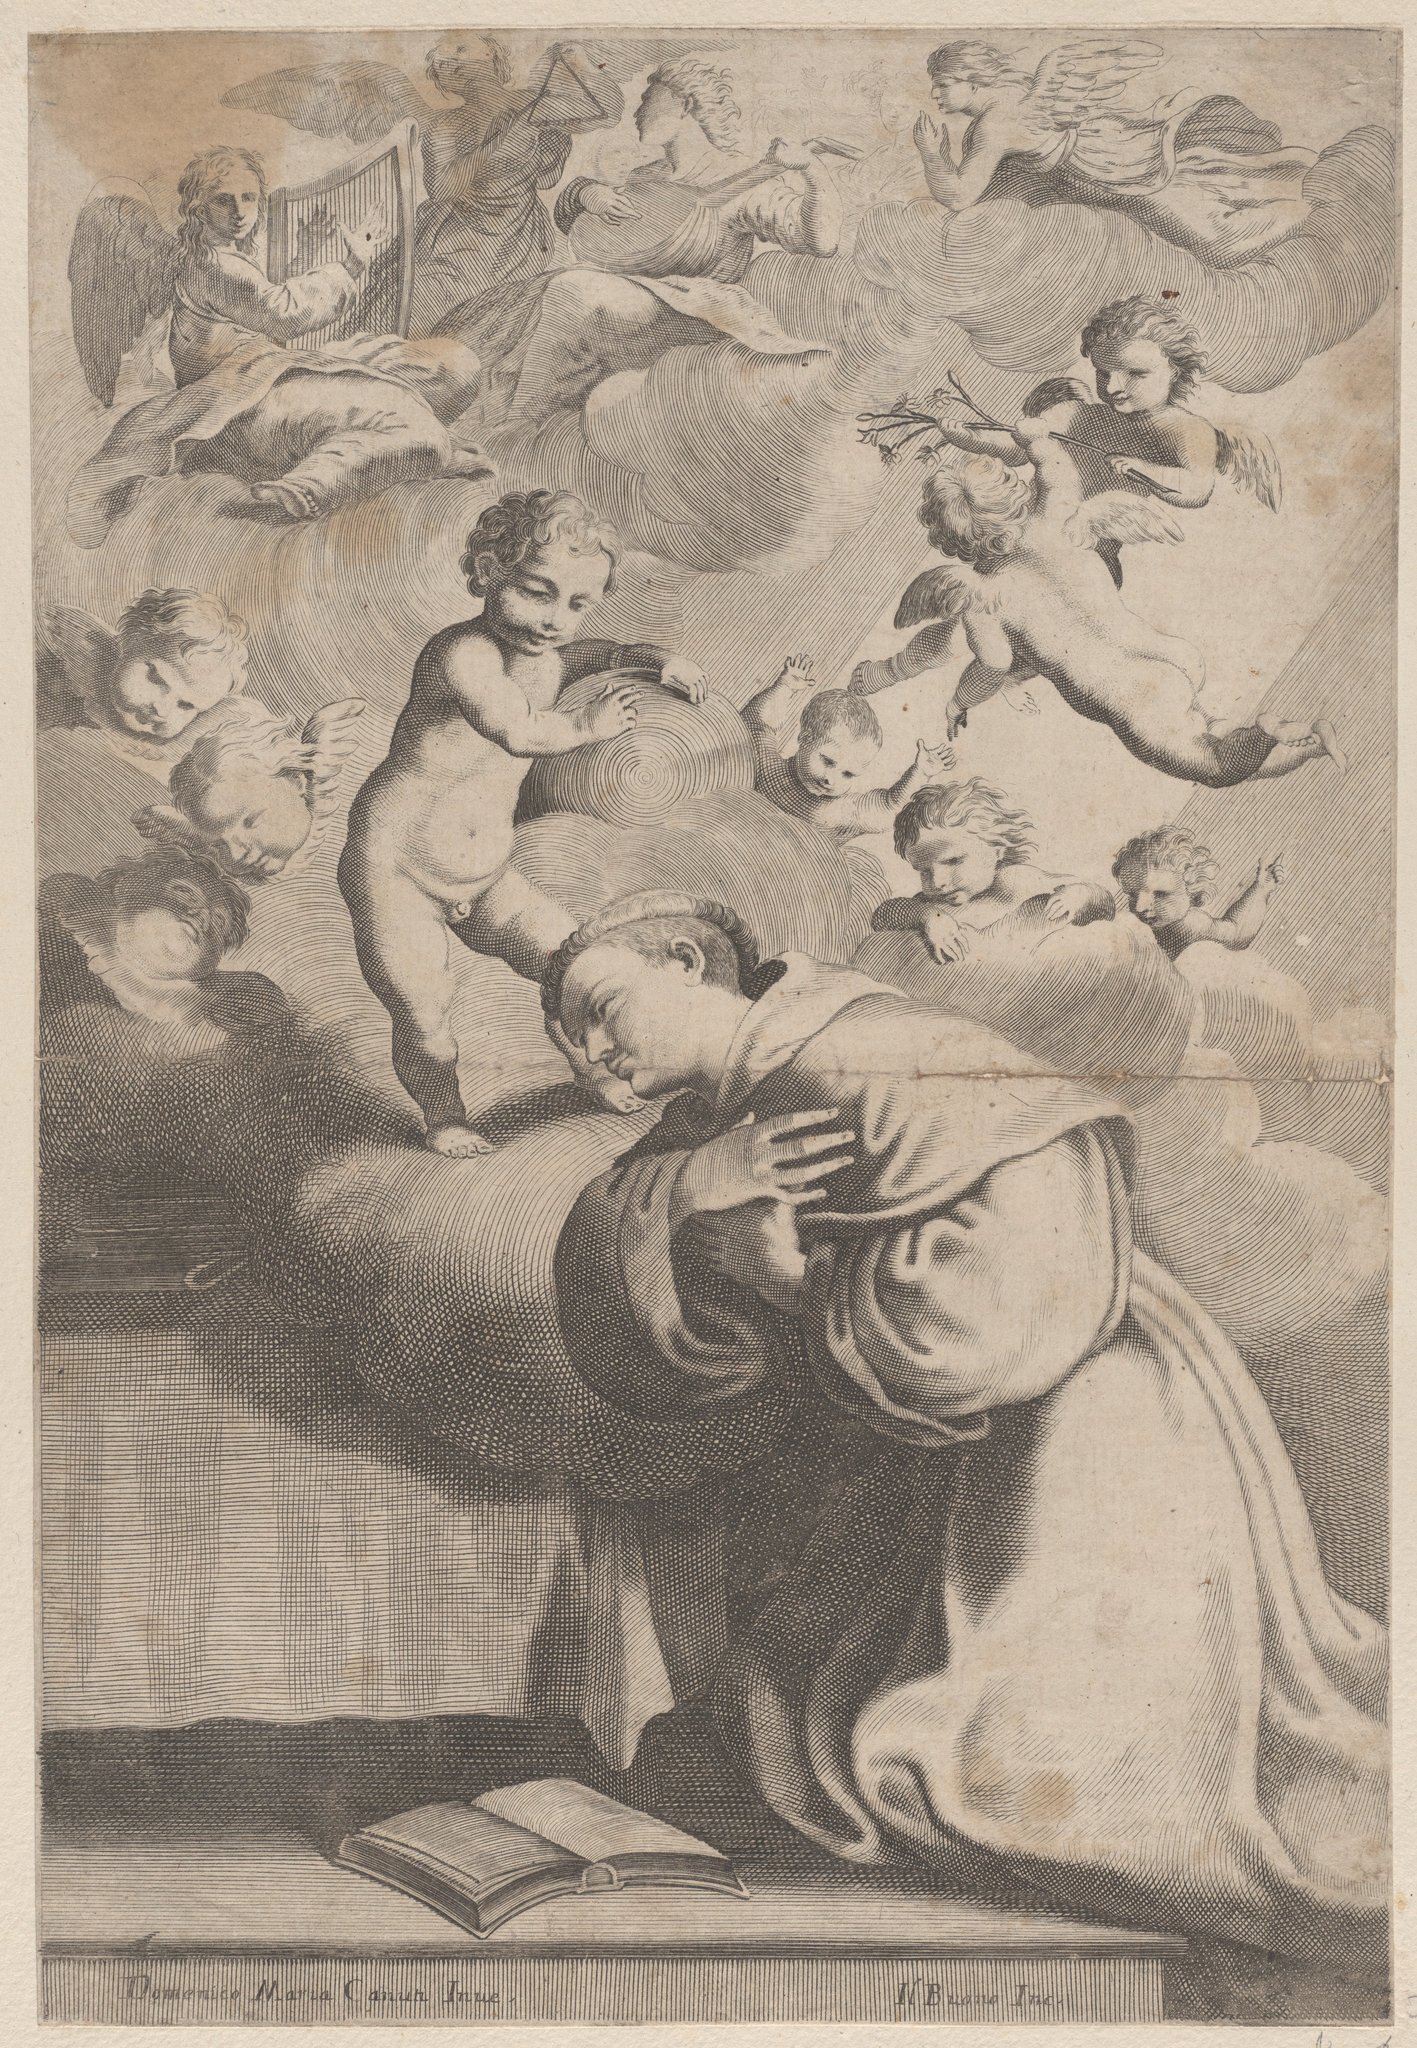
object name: print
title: A male saint kneeling before the Christ child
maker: Anonymous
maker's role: artist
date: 1670-1731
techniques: engraving